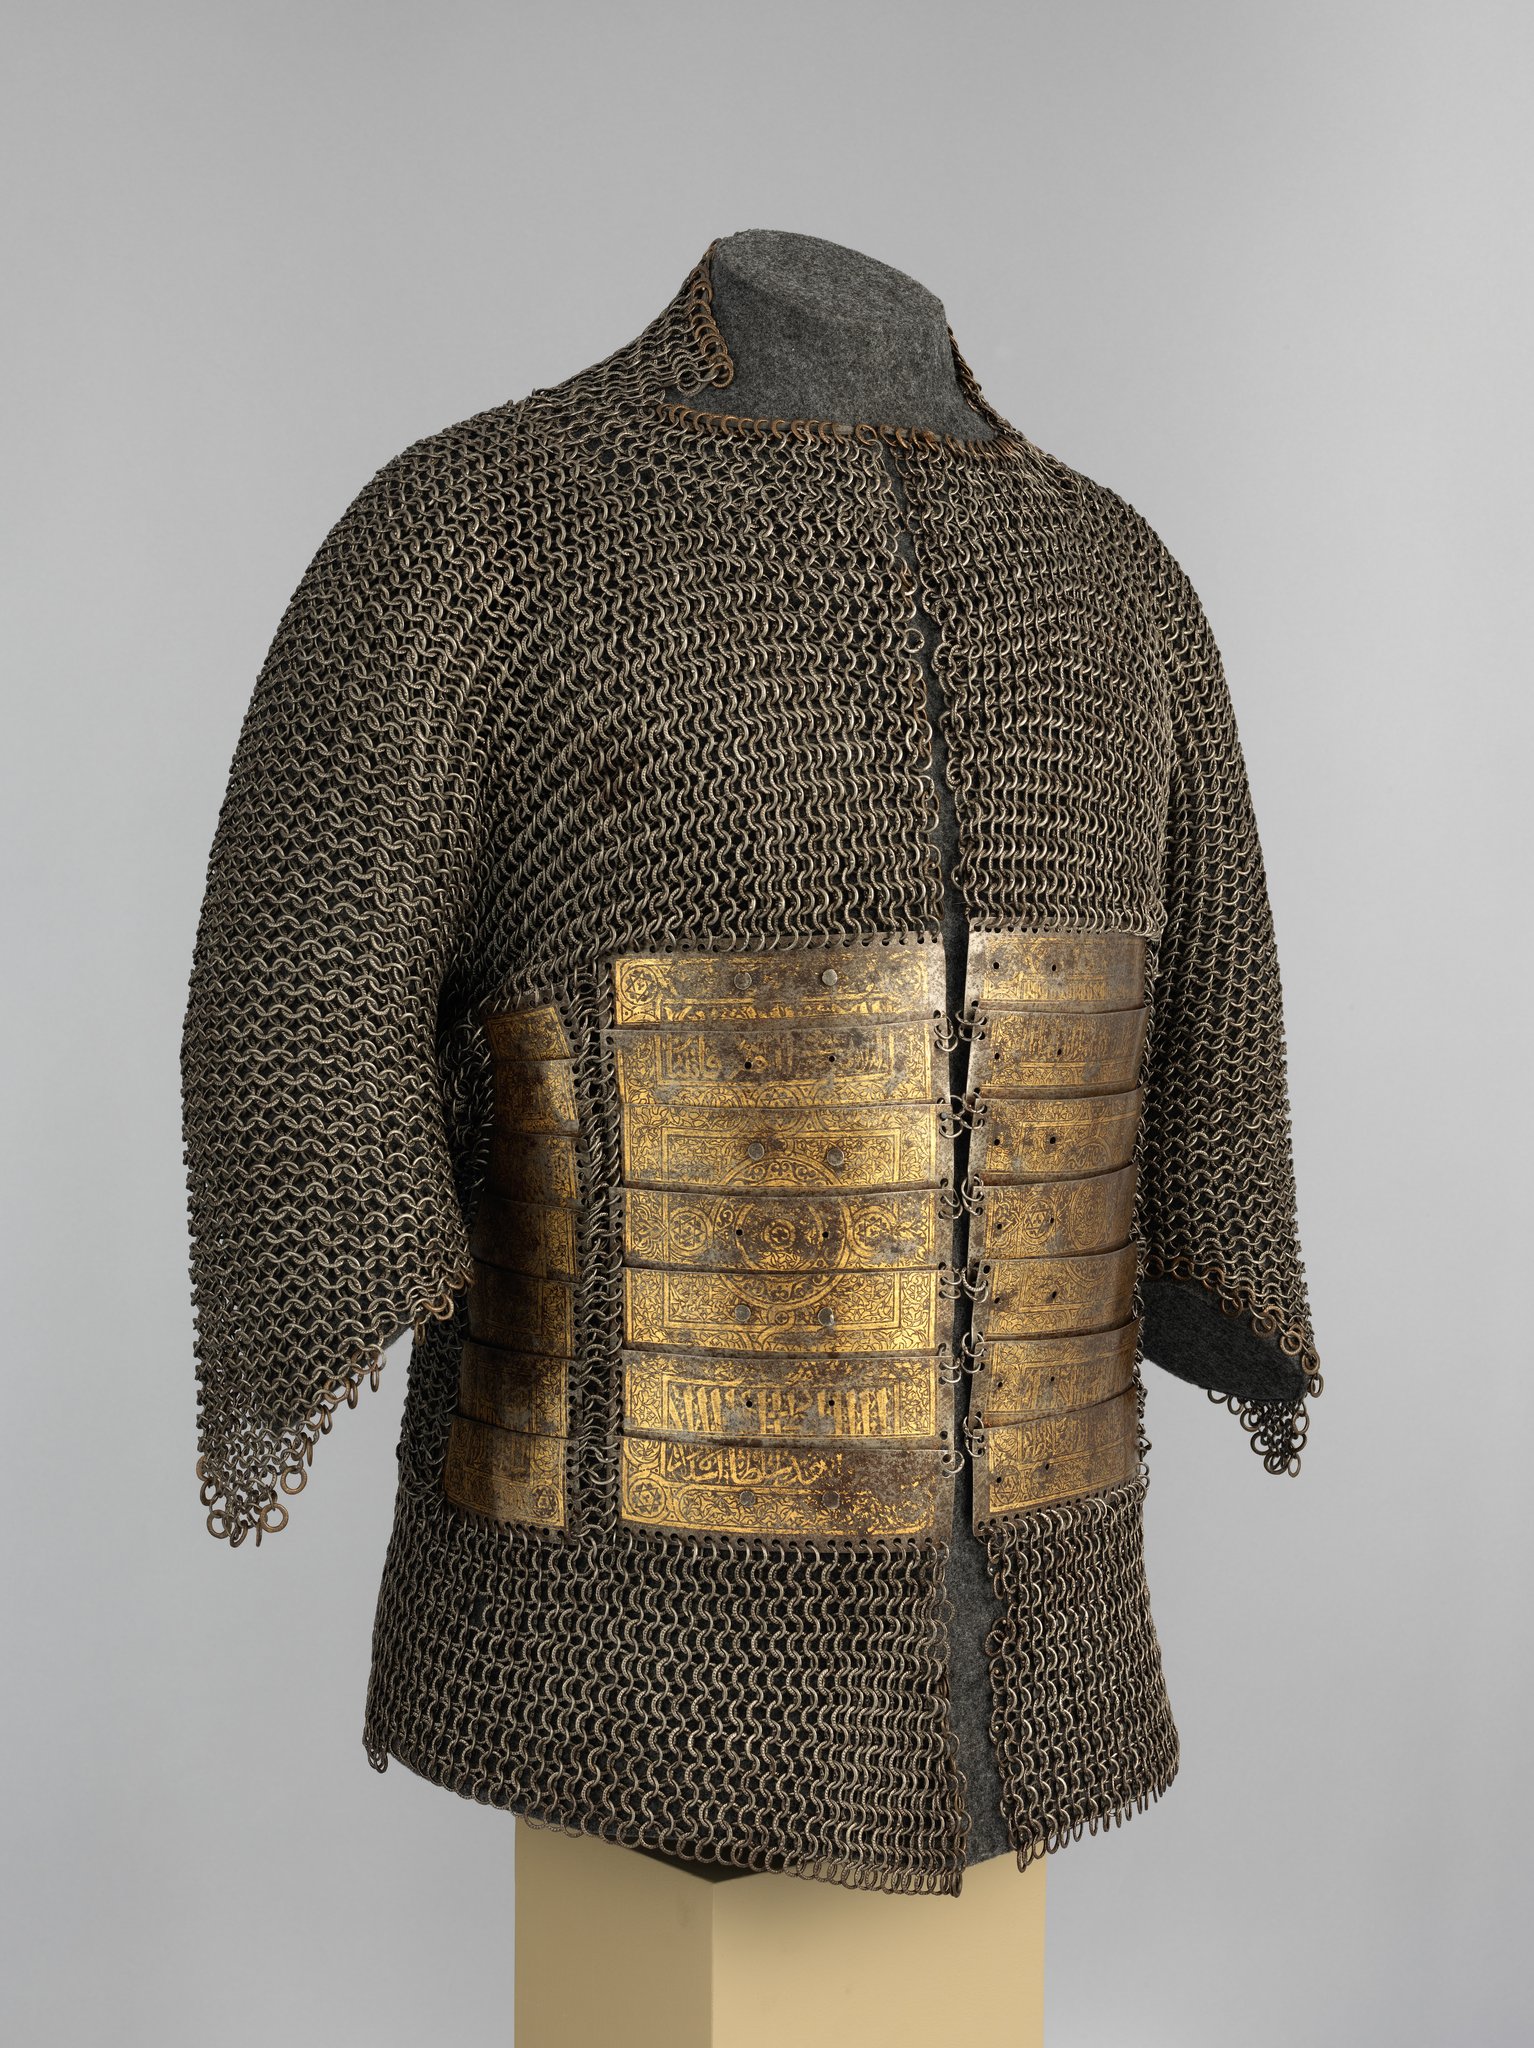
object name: shirt of mail and plate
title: Shirt of Mail and Plate of Al-Ashraf Sayf ad-Din Qaitbay (ca. 1416/18–1496), 18th Burji Mamluk Sultan of Egypt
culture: egyptian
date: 1468-1496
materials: copper alloy, gold, iron, steel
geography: syria